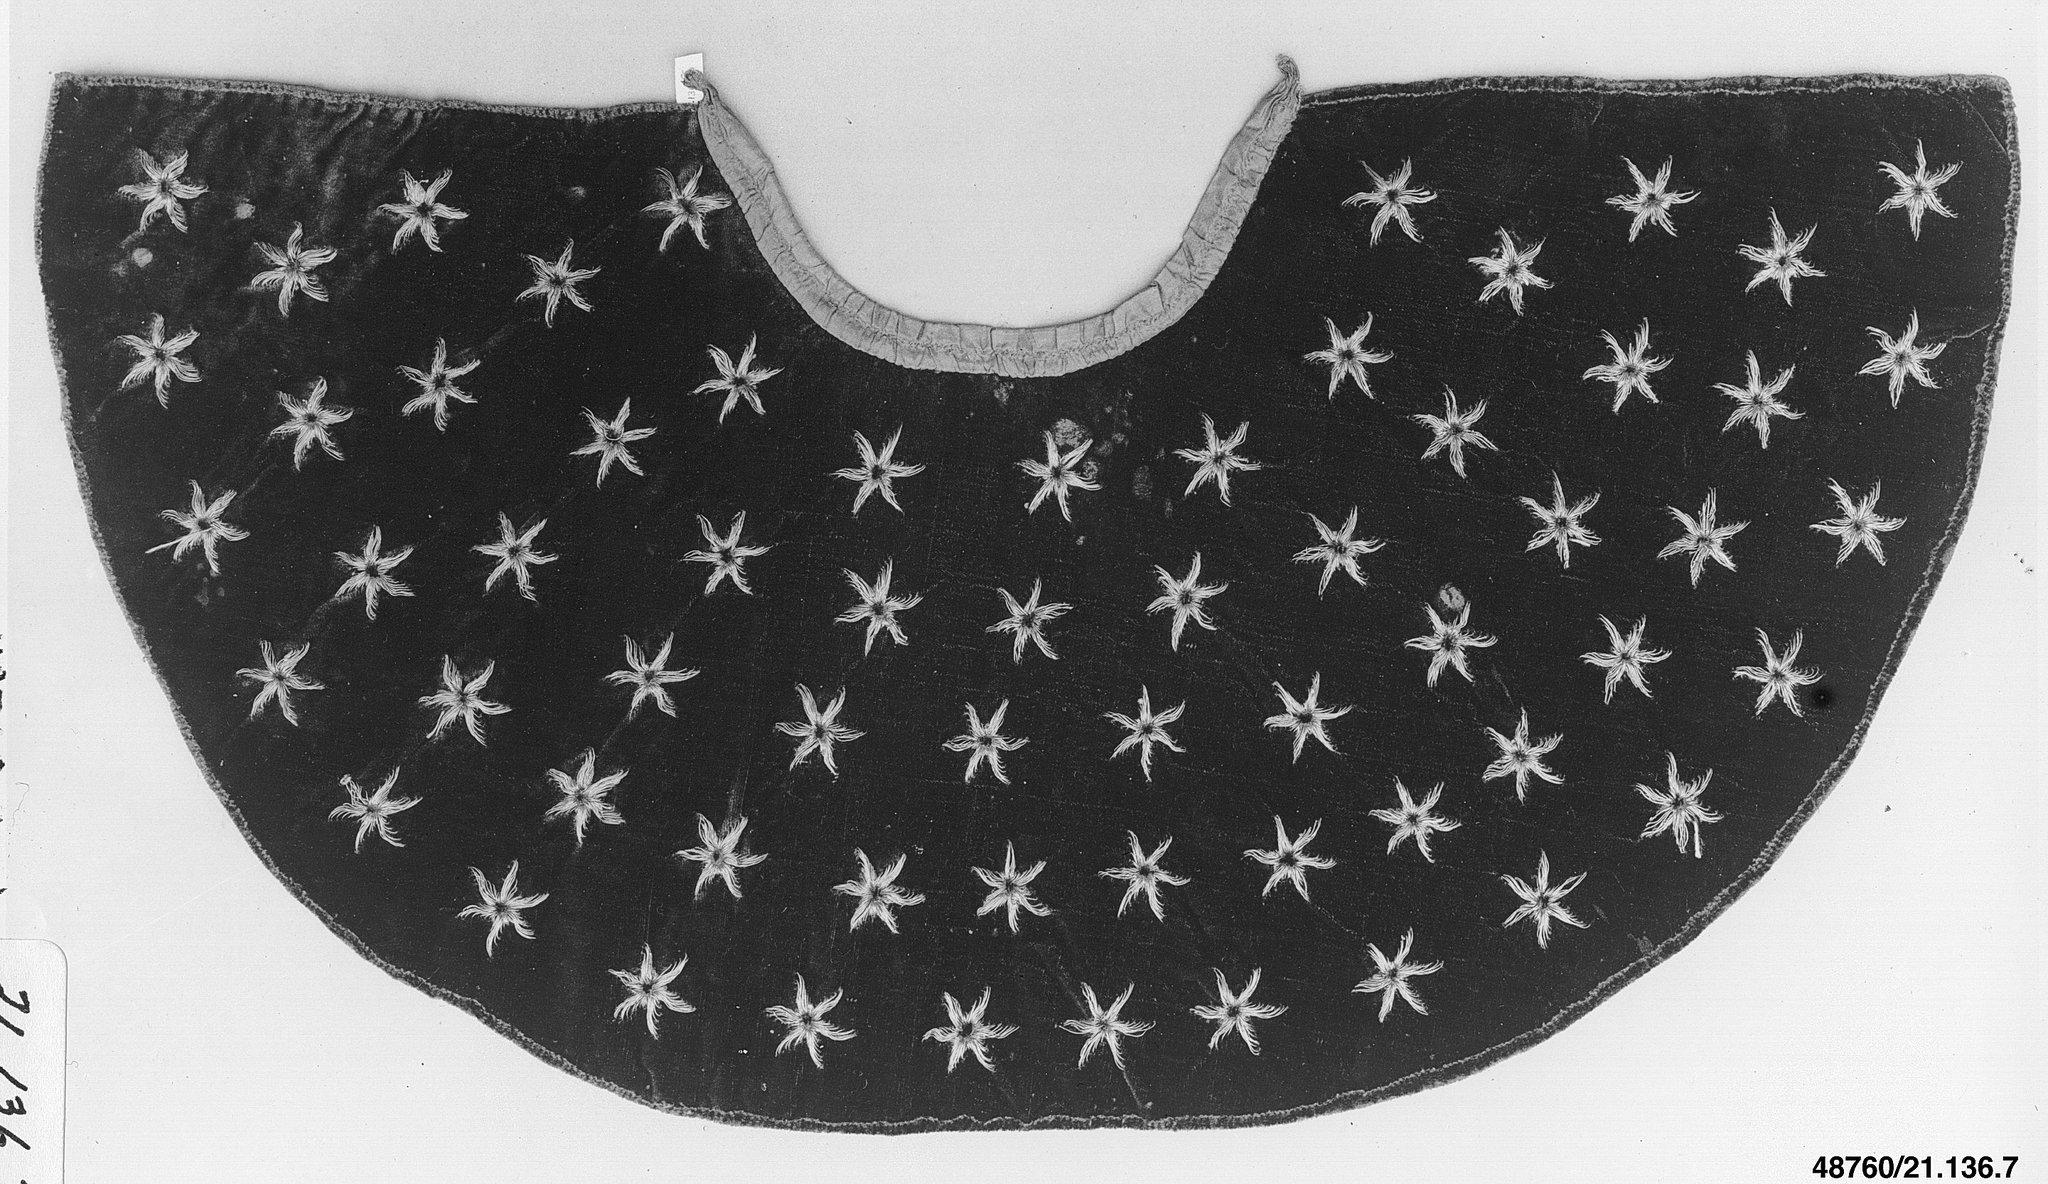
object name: statue robe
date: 1601-1700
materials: metal thread, silk